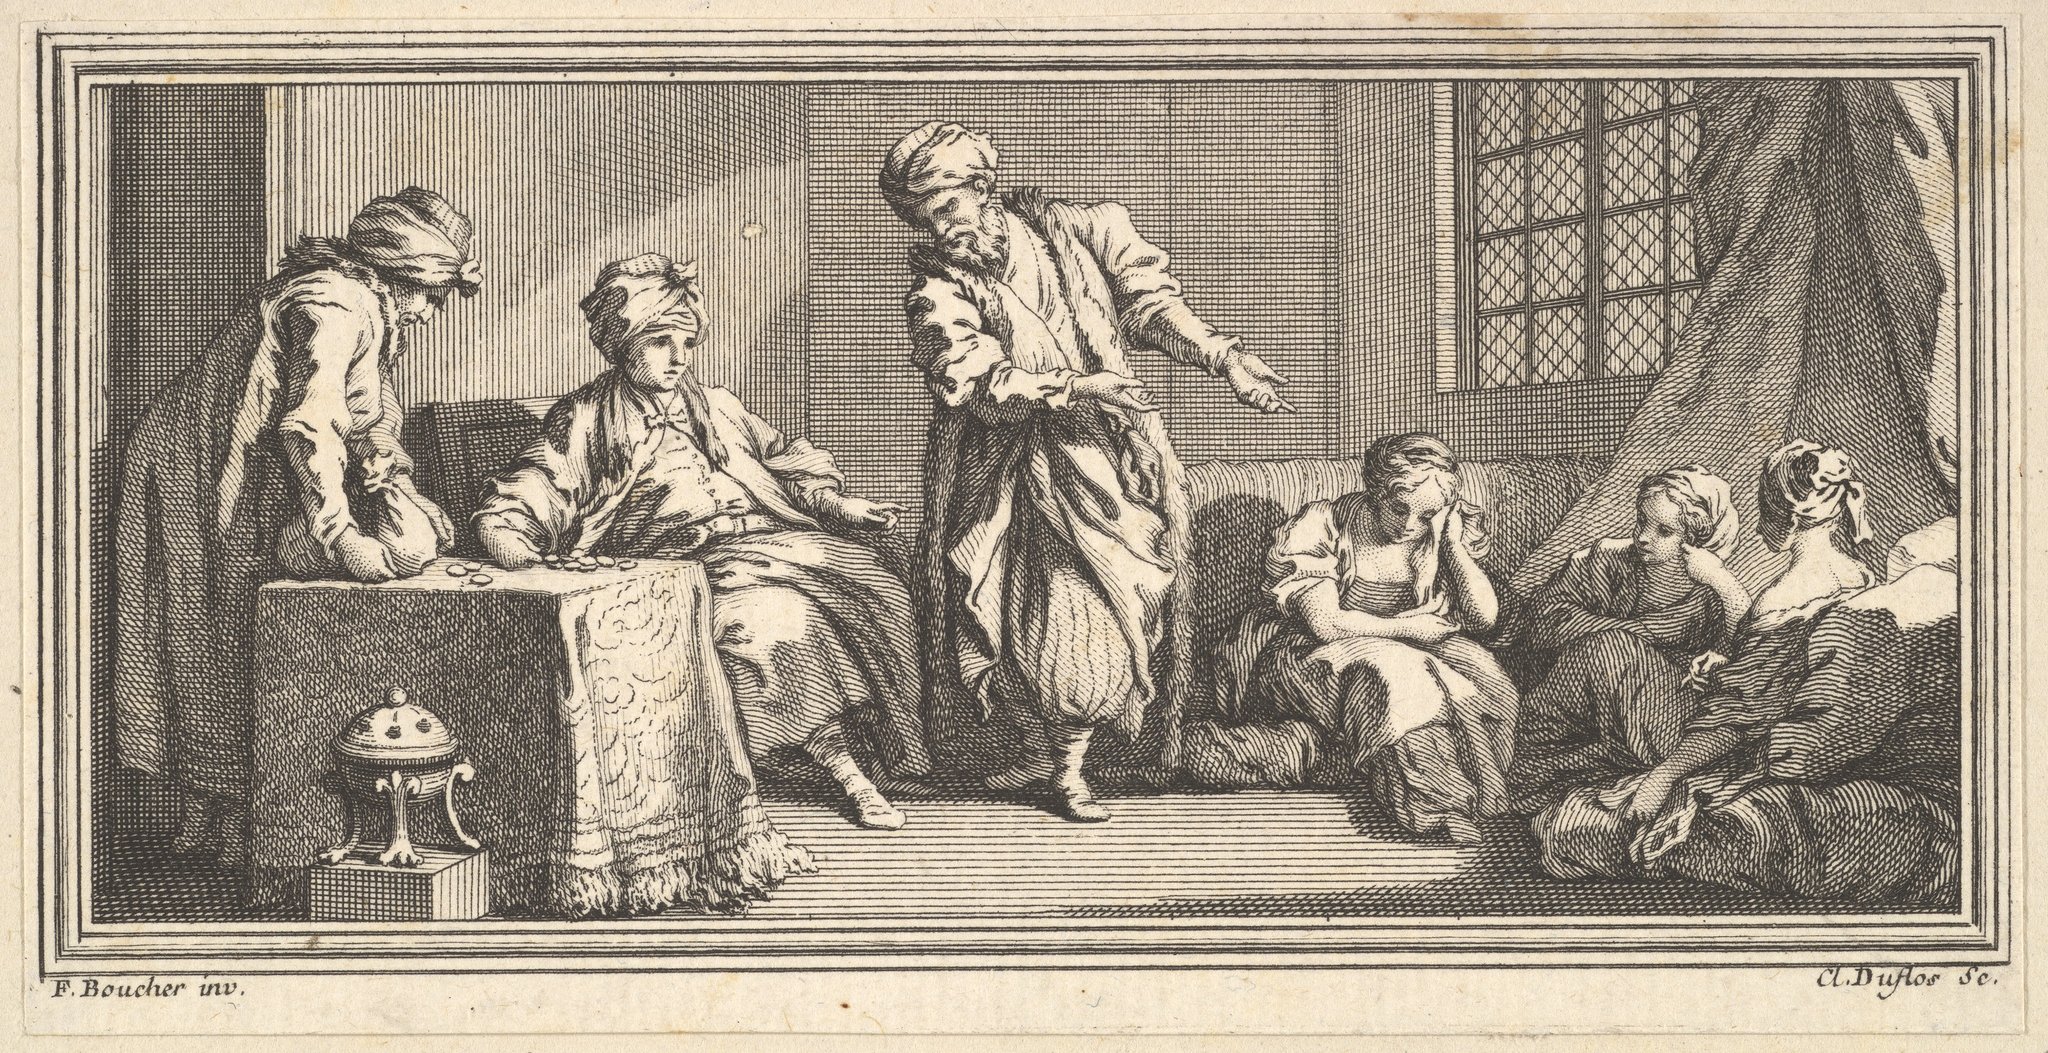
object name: print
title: The Slave Merchant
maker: claude augustin duflos le jeune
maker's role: artist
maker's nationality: french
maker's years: 1700-1786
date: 1746-1747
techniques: engraving, etching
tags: men,women,merchants